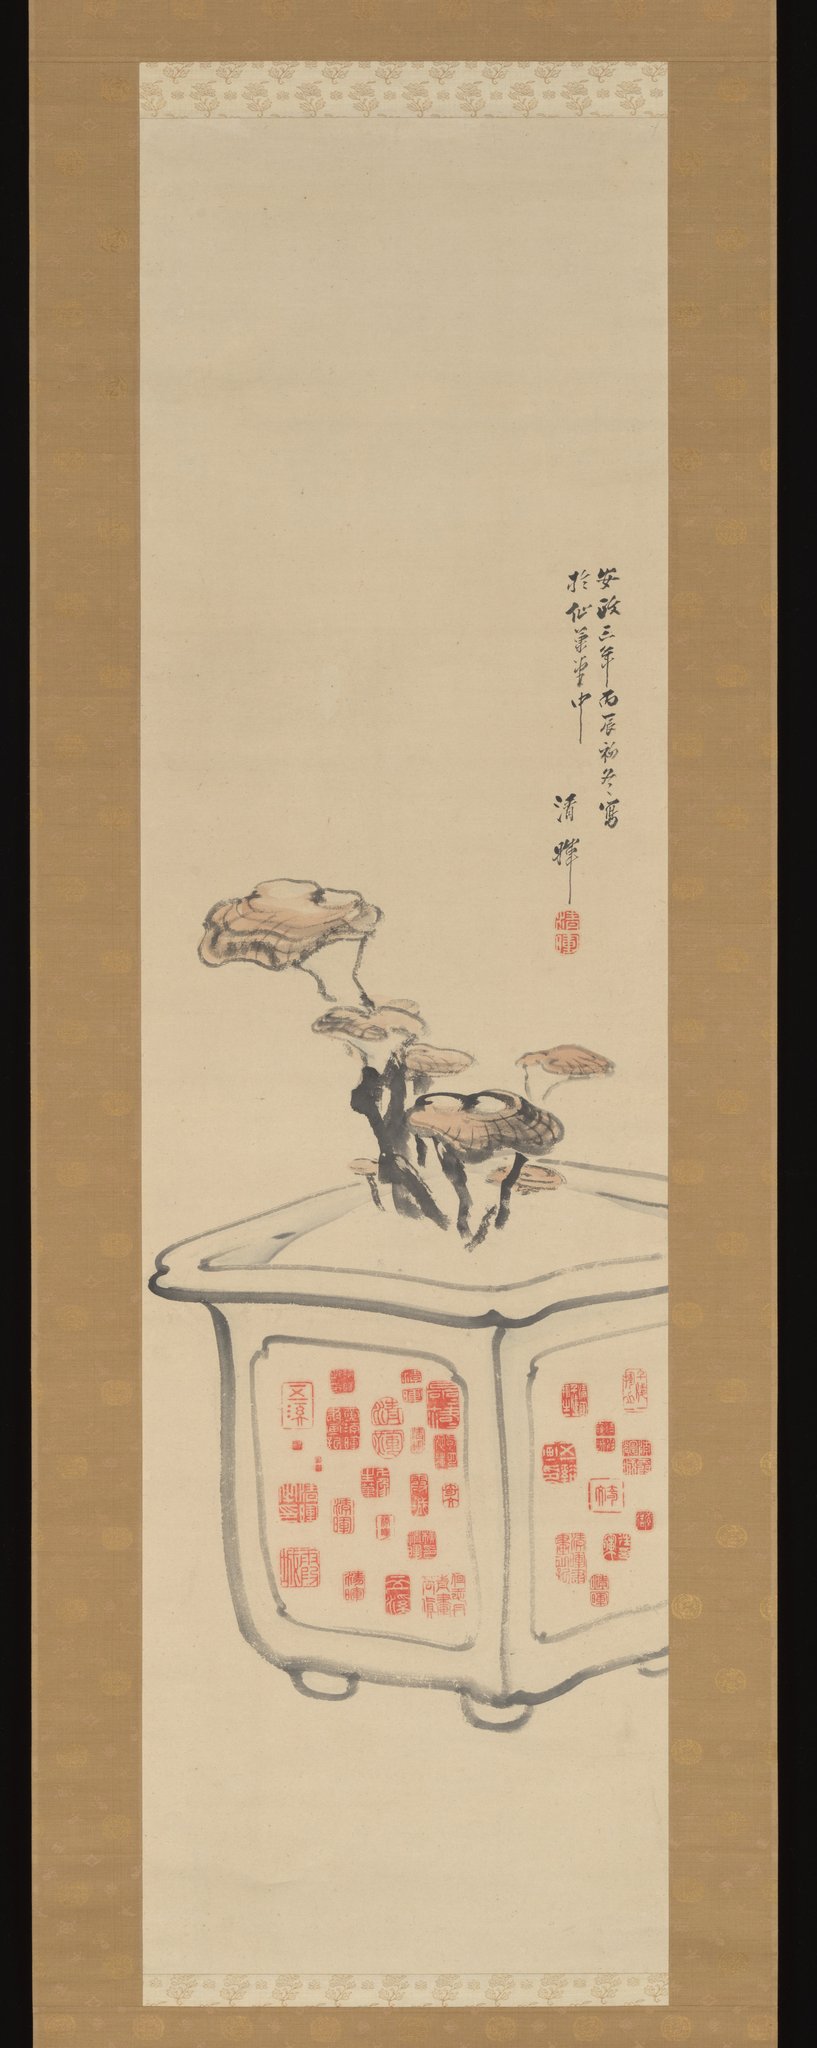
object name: hanging scroll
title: Plant and Seals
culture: japanese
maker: yokoyama seiki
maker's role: artist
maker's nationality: japanese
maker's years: 1793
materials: ink, paper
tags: plants